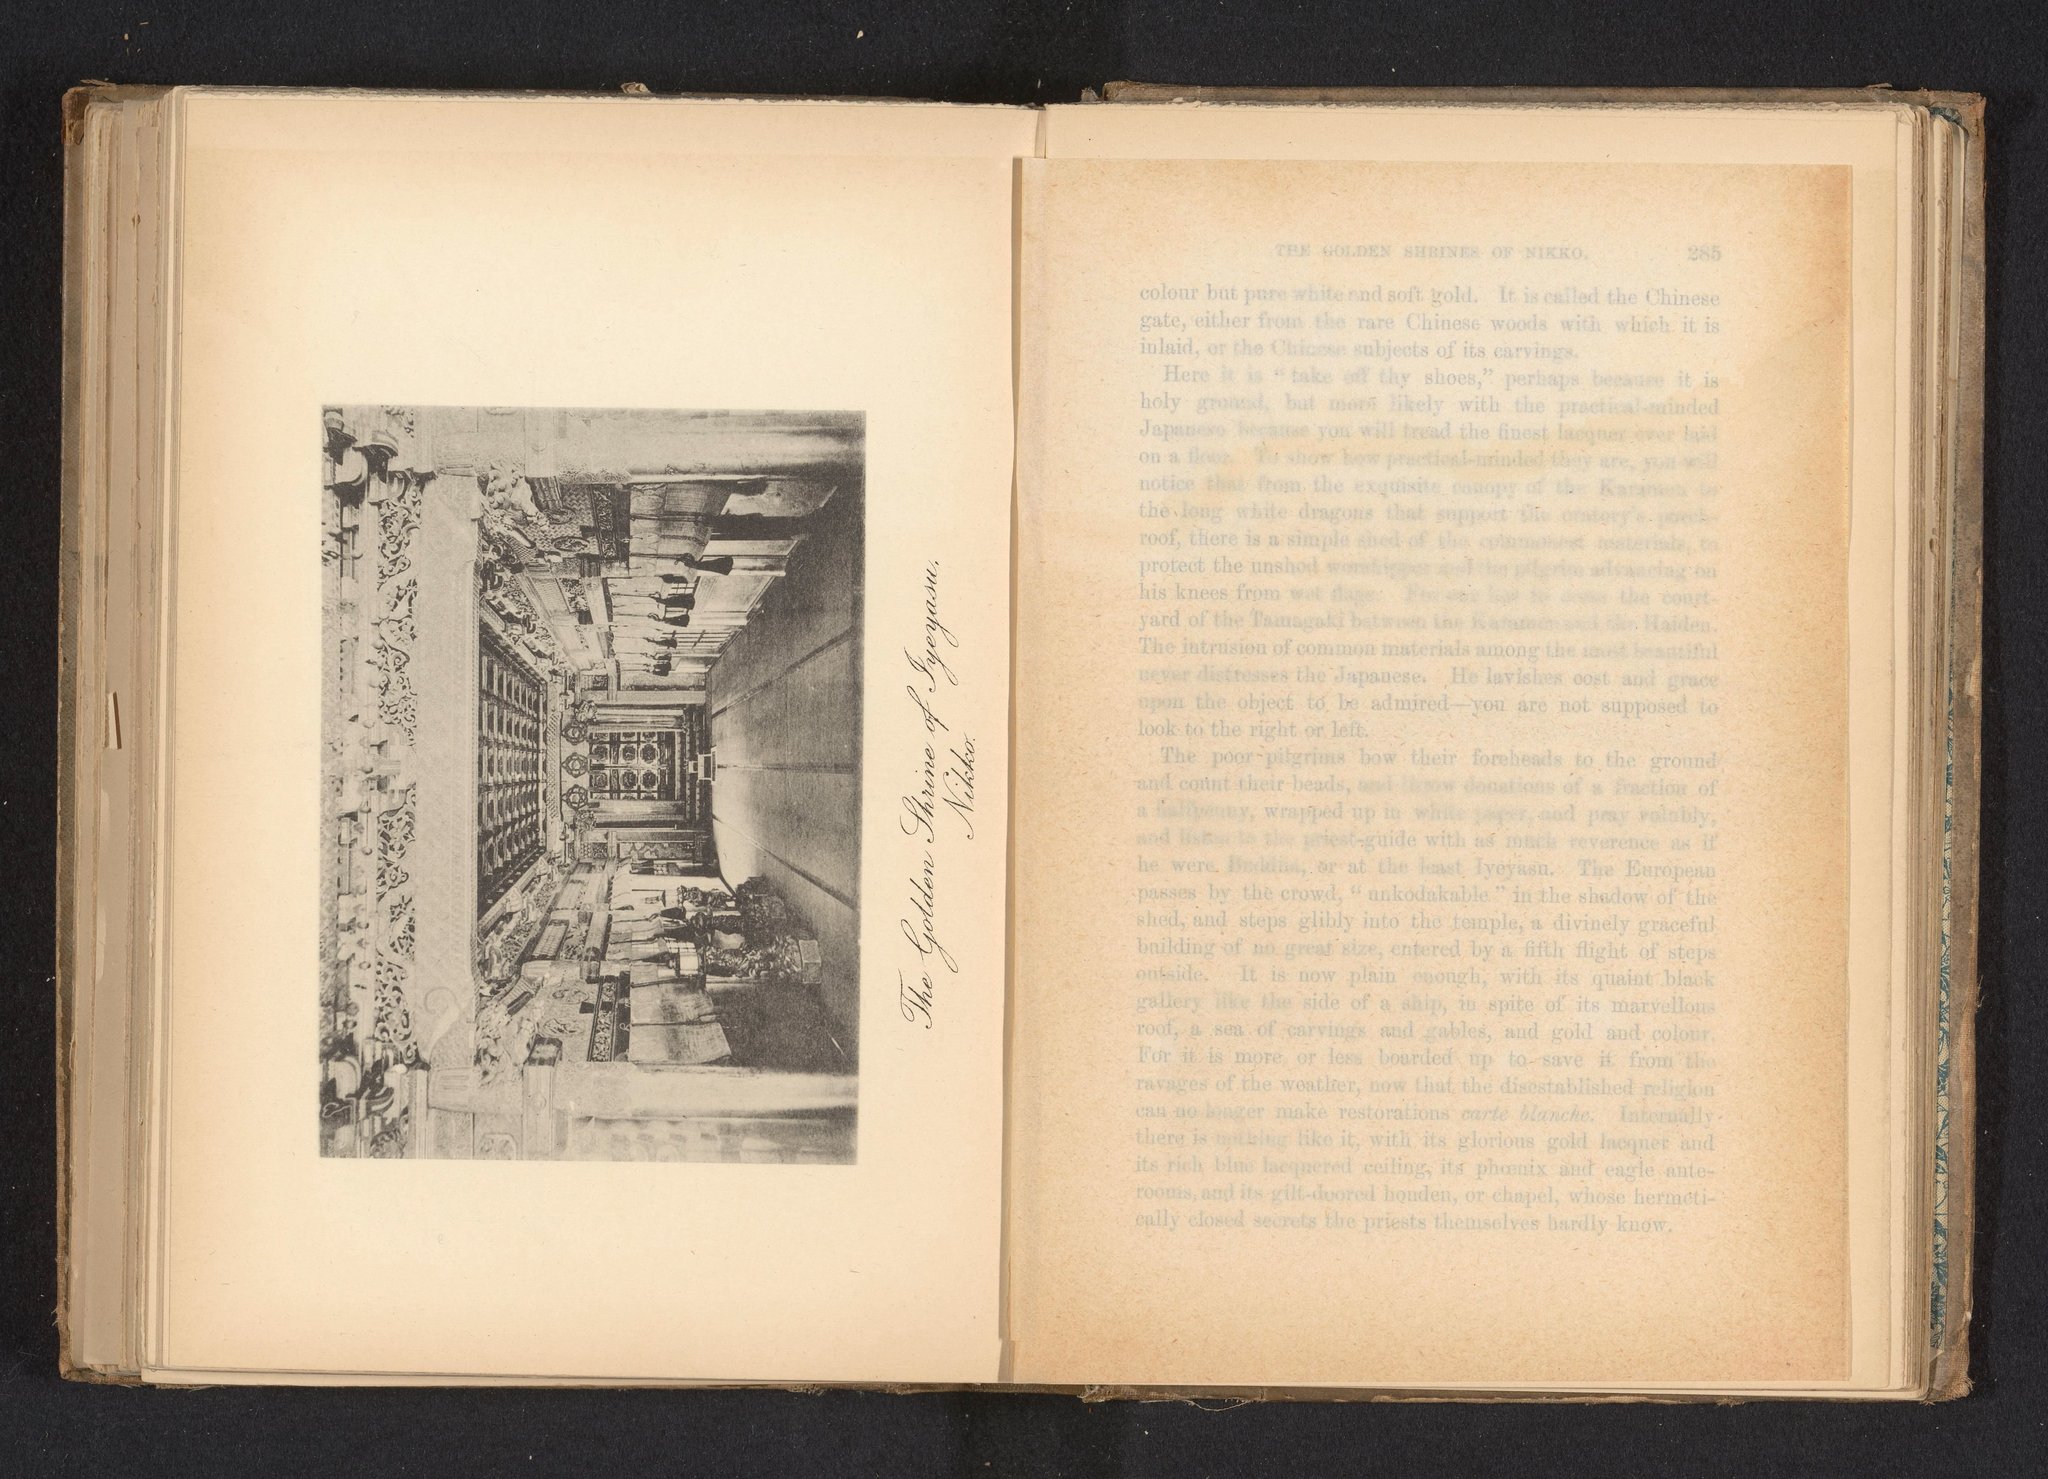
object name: photomechanical print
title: Interieur van een Toshogu heiligdom in Nikko in Japan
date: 1882-1892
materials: paper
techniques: photograph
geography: japan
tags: temple, shrine ~ shinto